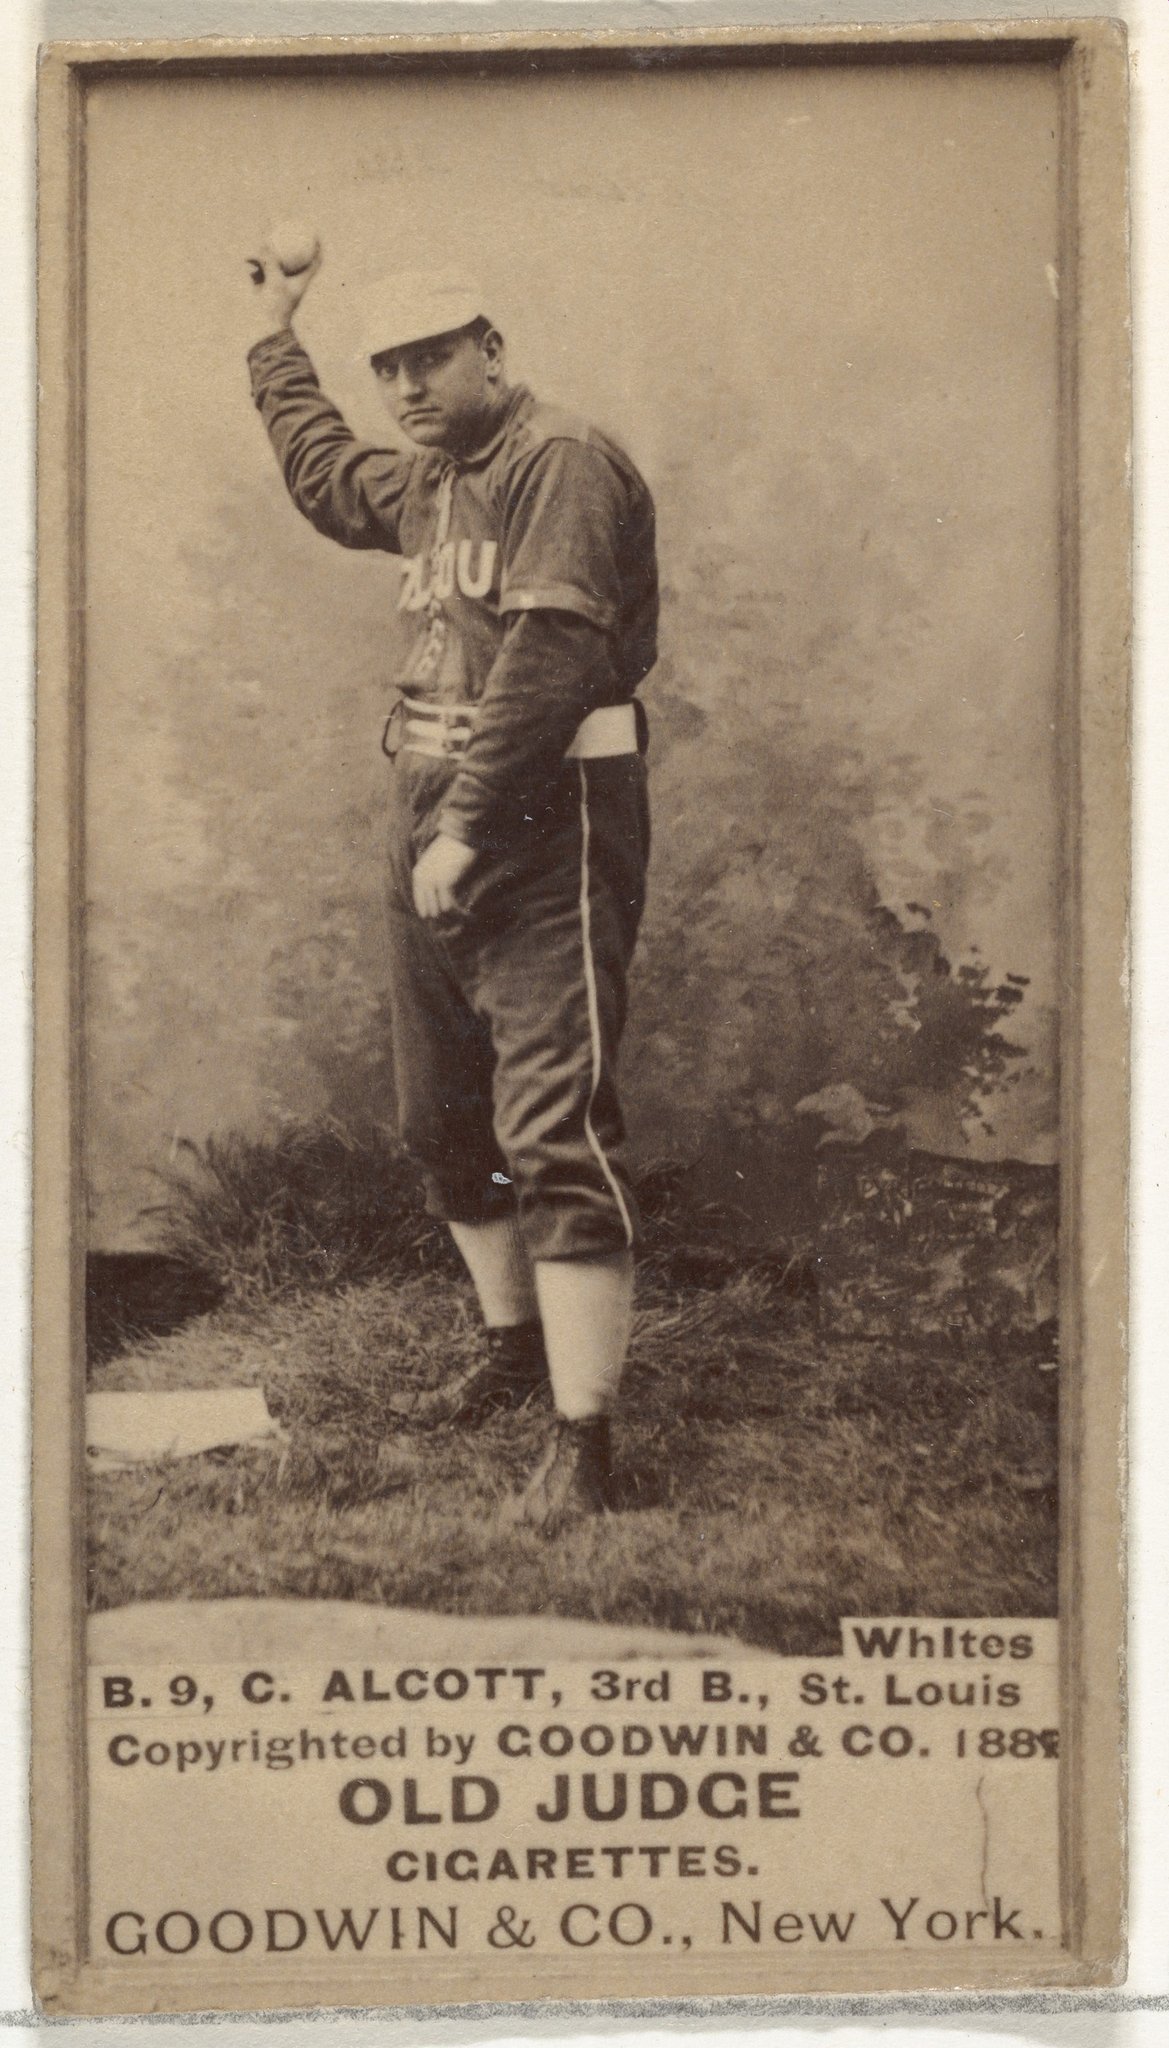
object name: baseball card, photograph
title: Alcott, 3rd Base, St. Louis Whites, from the Old Judge series (N172) for Old Judge Cigarettes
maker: goodwin & company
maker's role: publisher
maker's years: 1850-1950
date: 1888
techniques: albumen silver print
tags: men,portraits,baseball,athletes